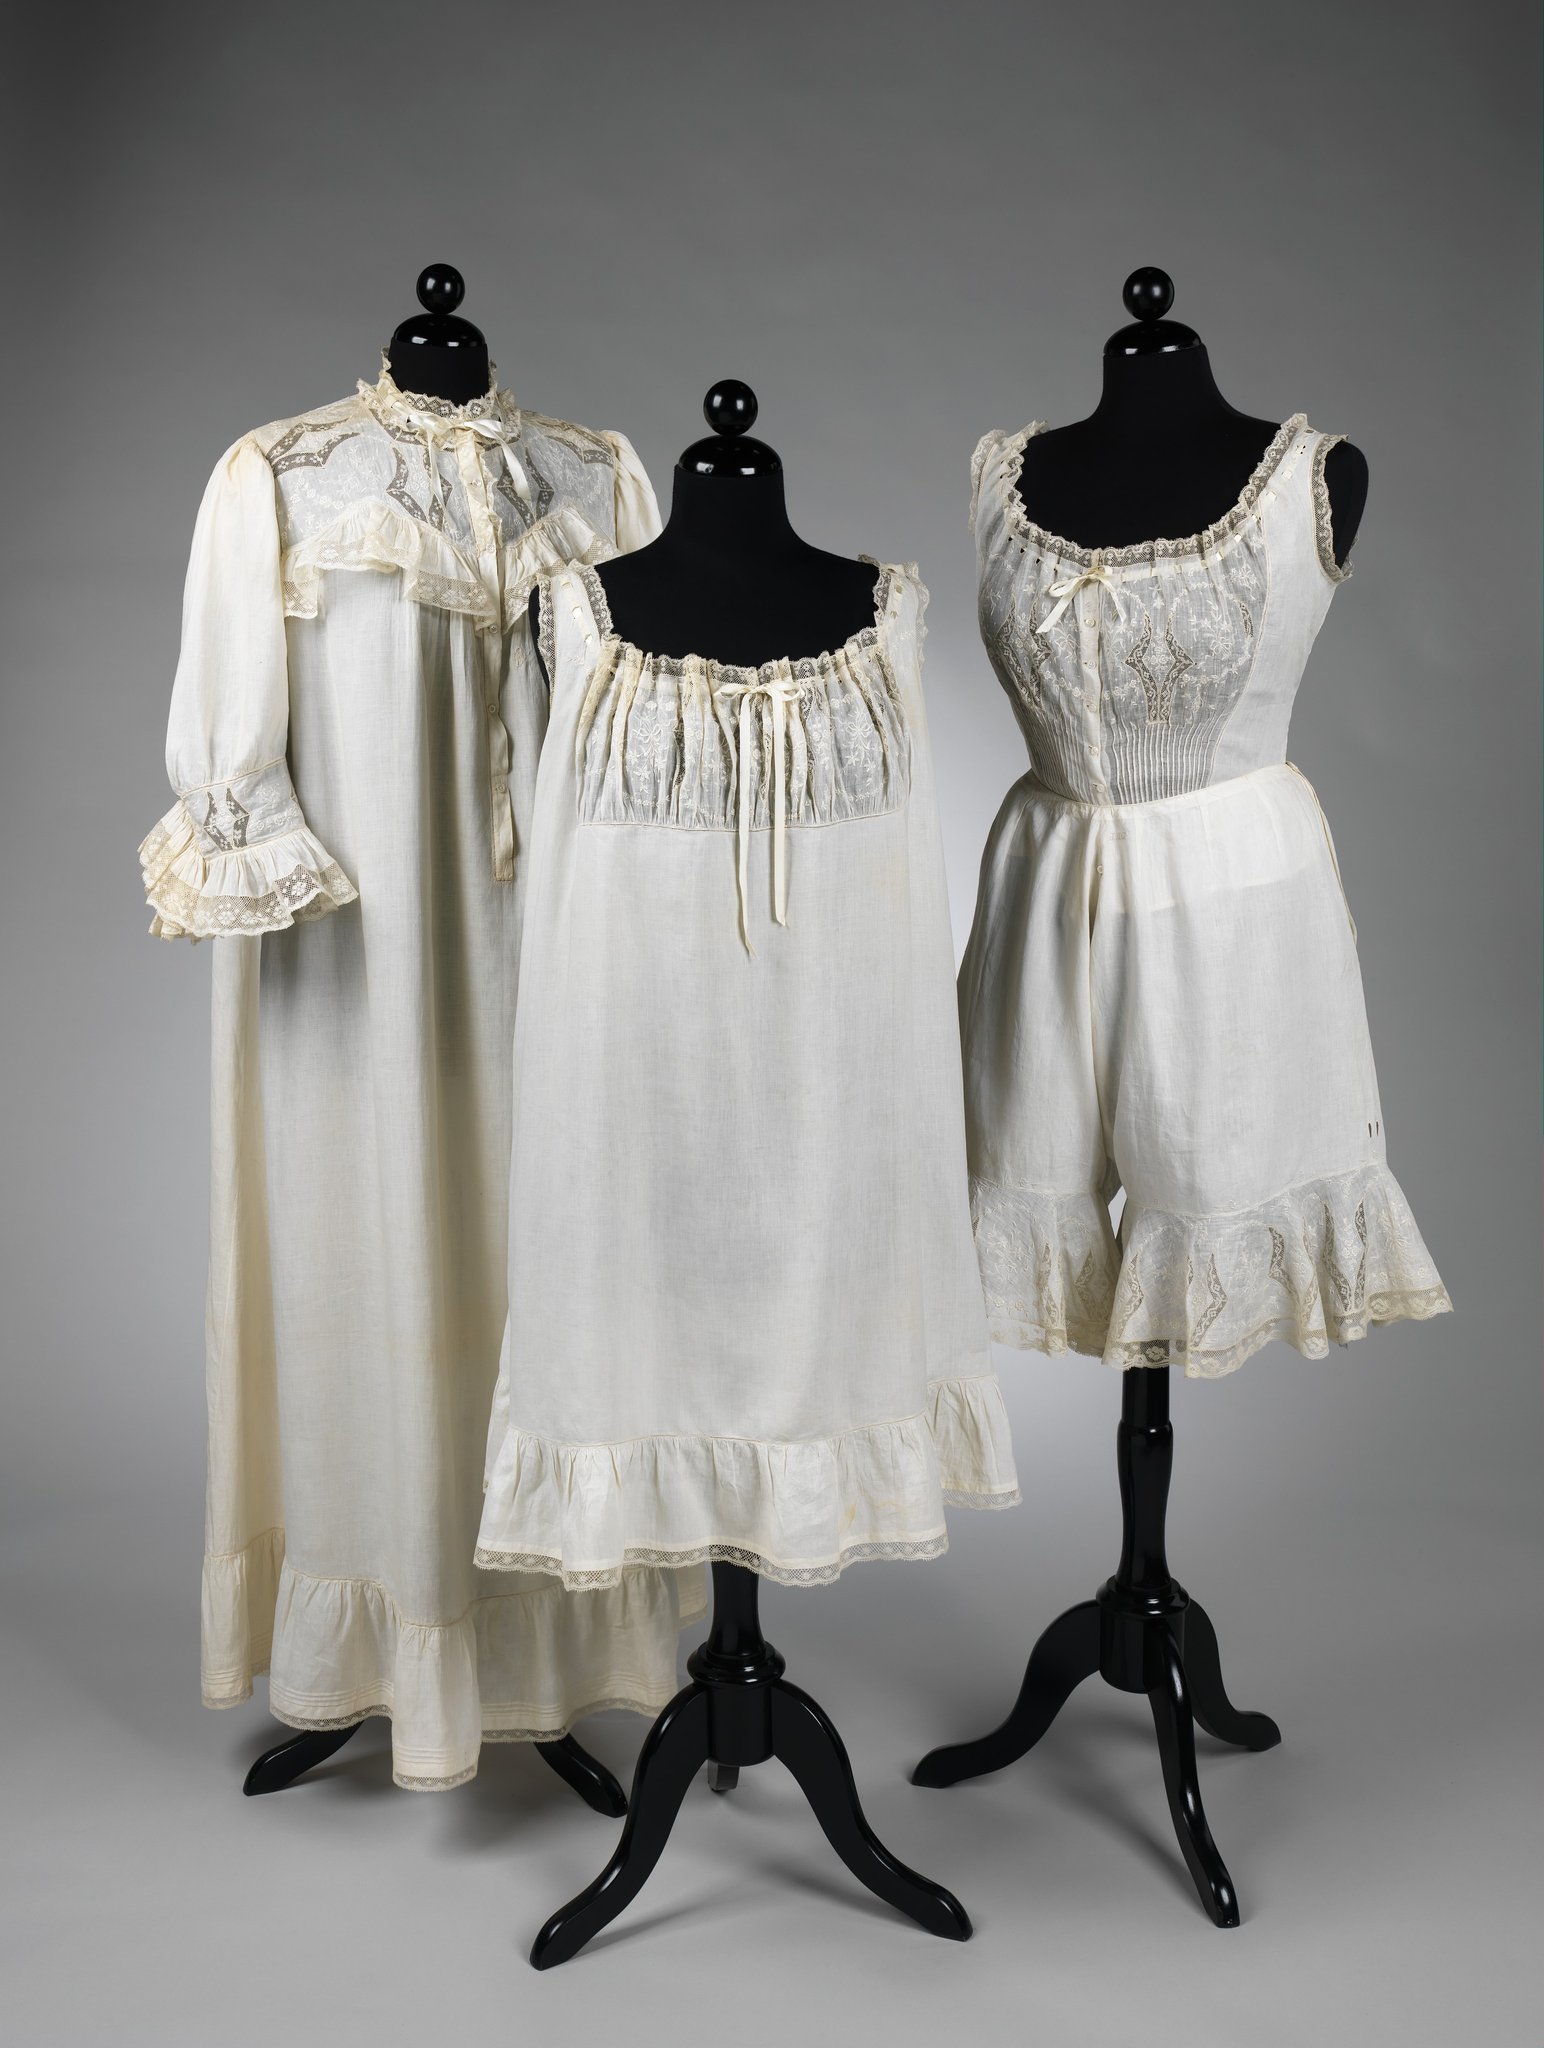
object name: lingerie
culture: american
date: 1895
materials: linen, silk